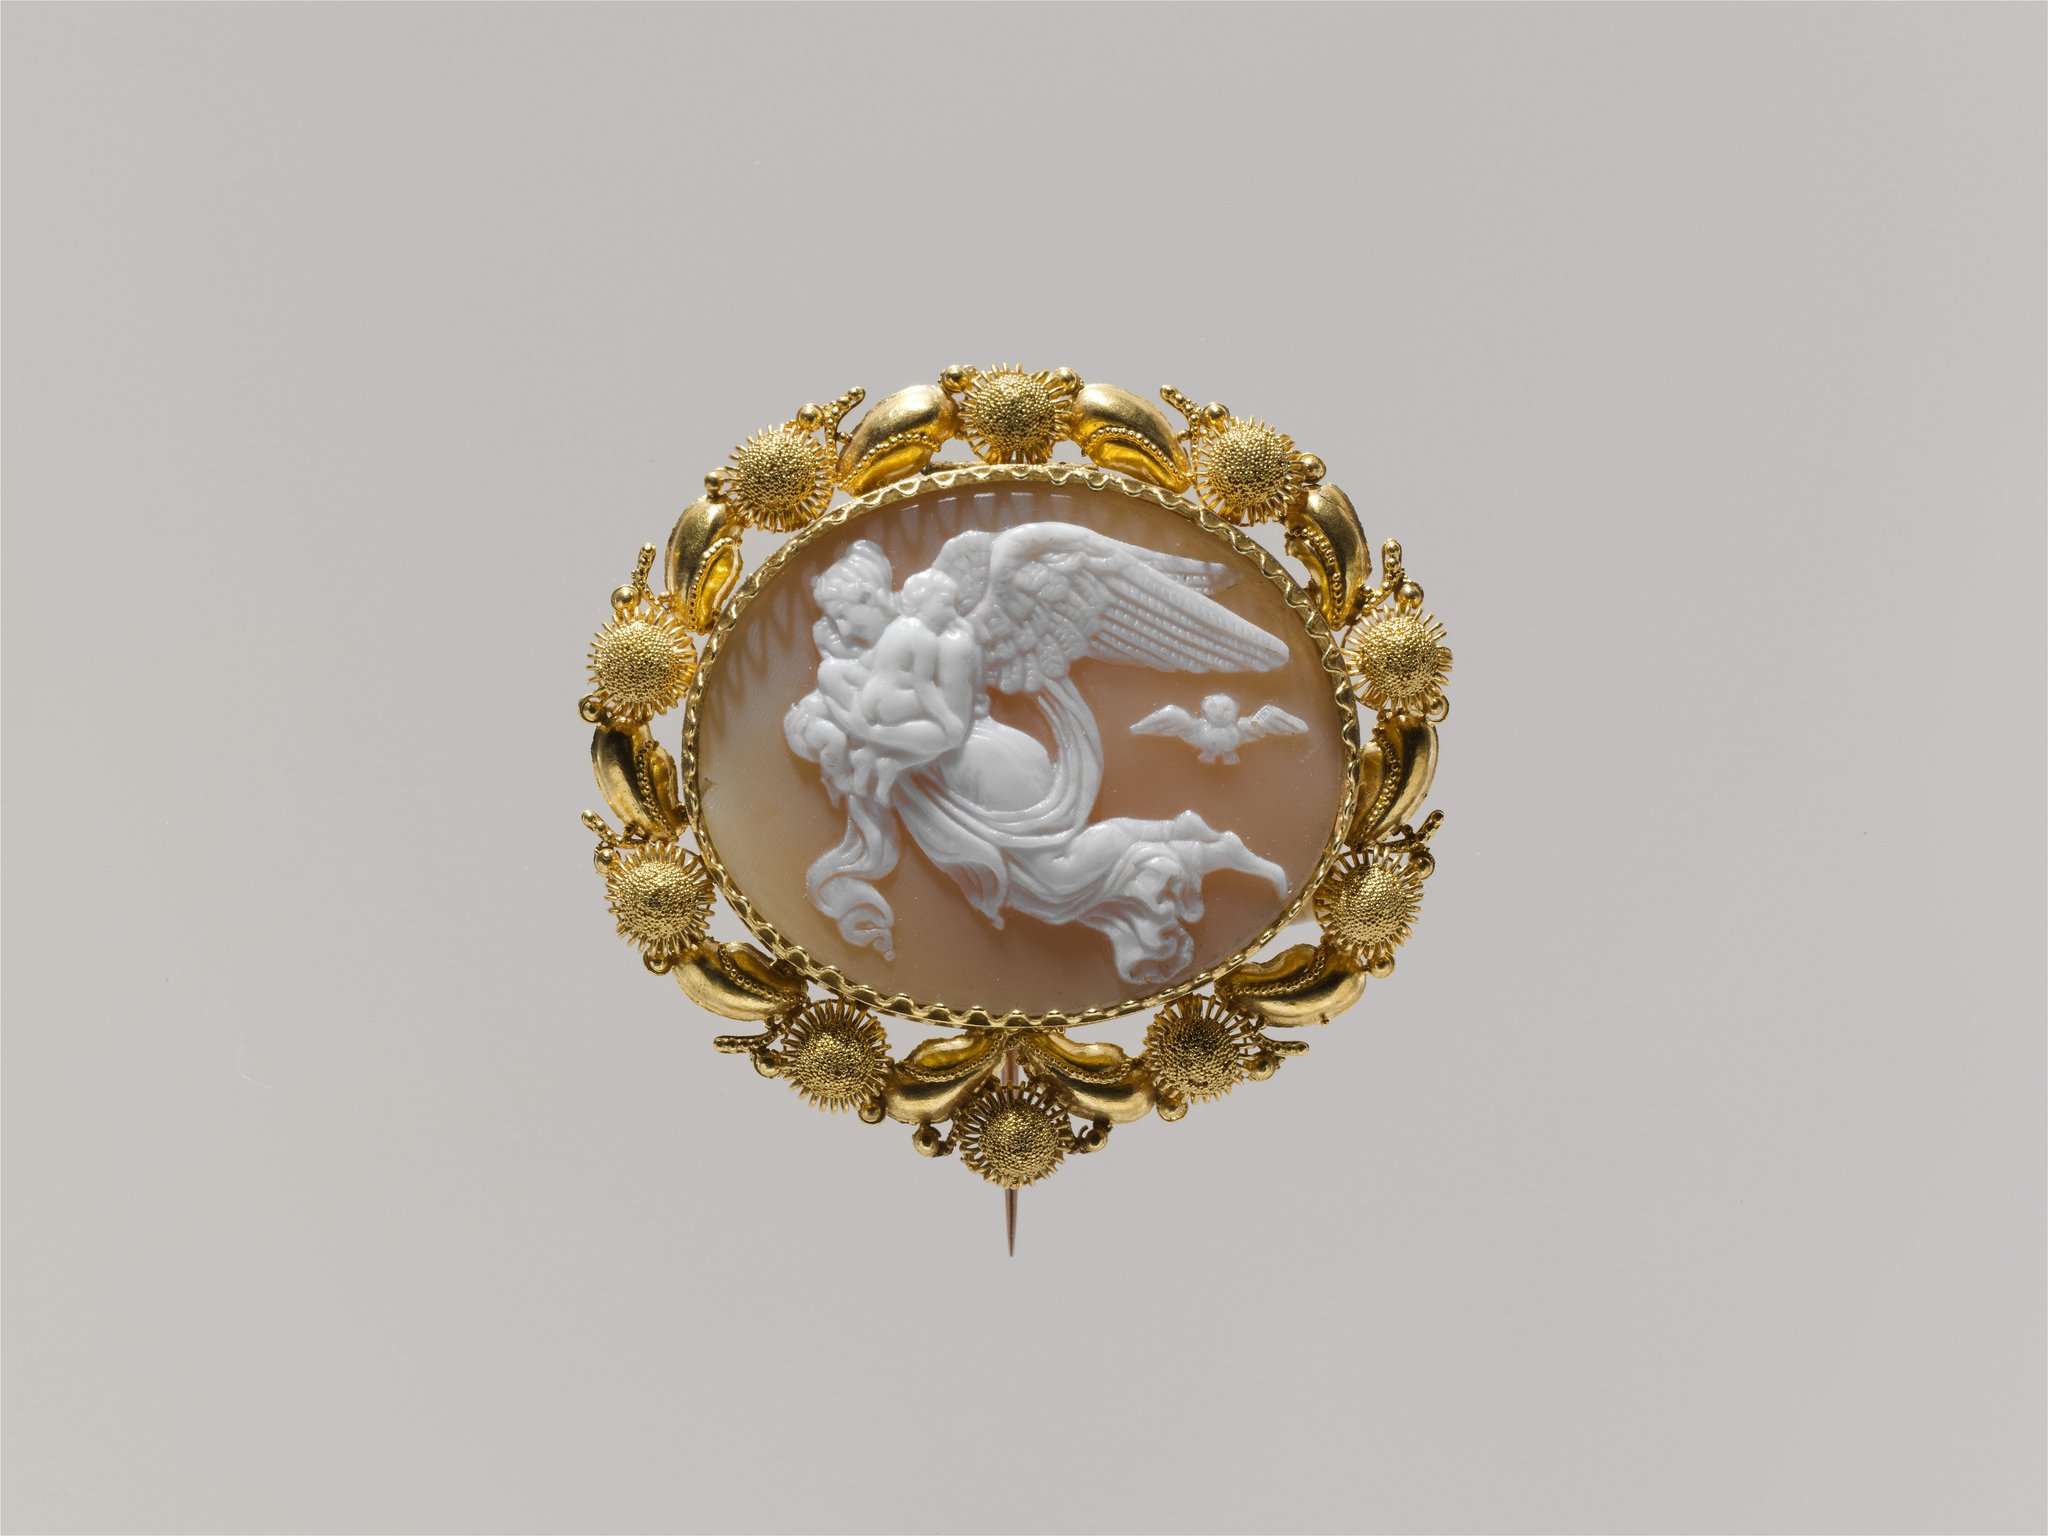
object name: pin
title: Pin (part of a set)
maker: bertel thorvaldsen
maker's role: artist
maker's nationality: danish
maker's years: 1770-1844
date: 1834-1866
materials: gold, shell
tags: sleeping,children,night